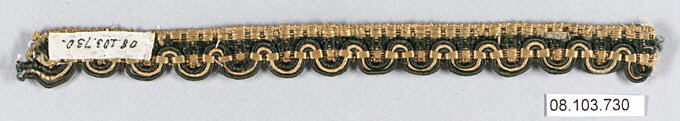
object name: gimp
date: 1834-1866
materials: silk